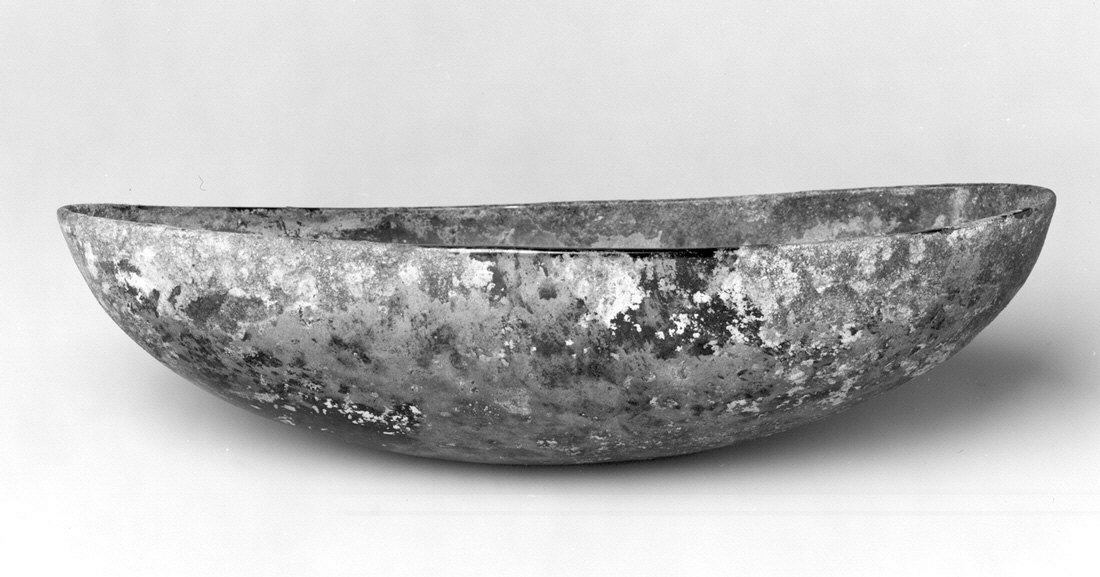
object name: bowl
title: Elliptical bowl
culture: sasanian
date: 601-700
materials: bronze, tin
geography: iran